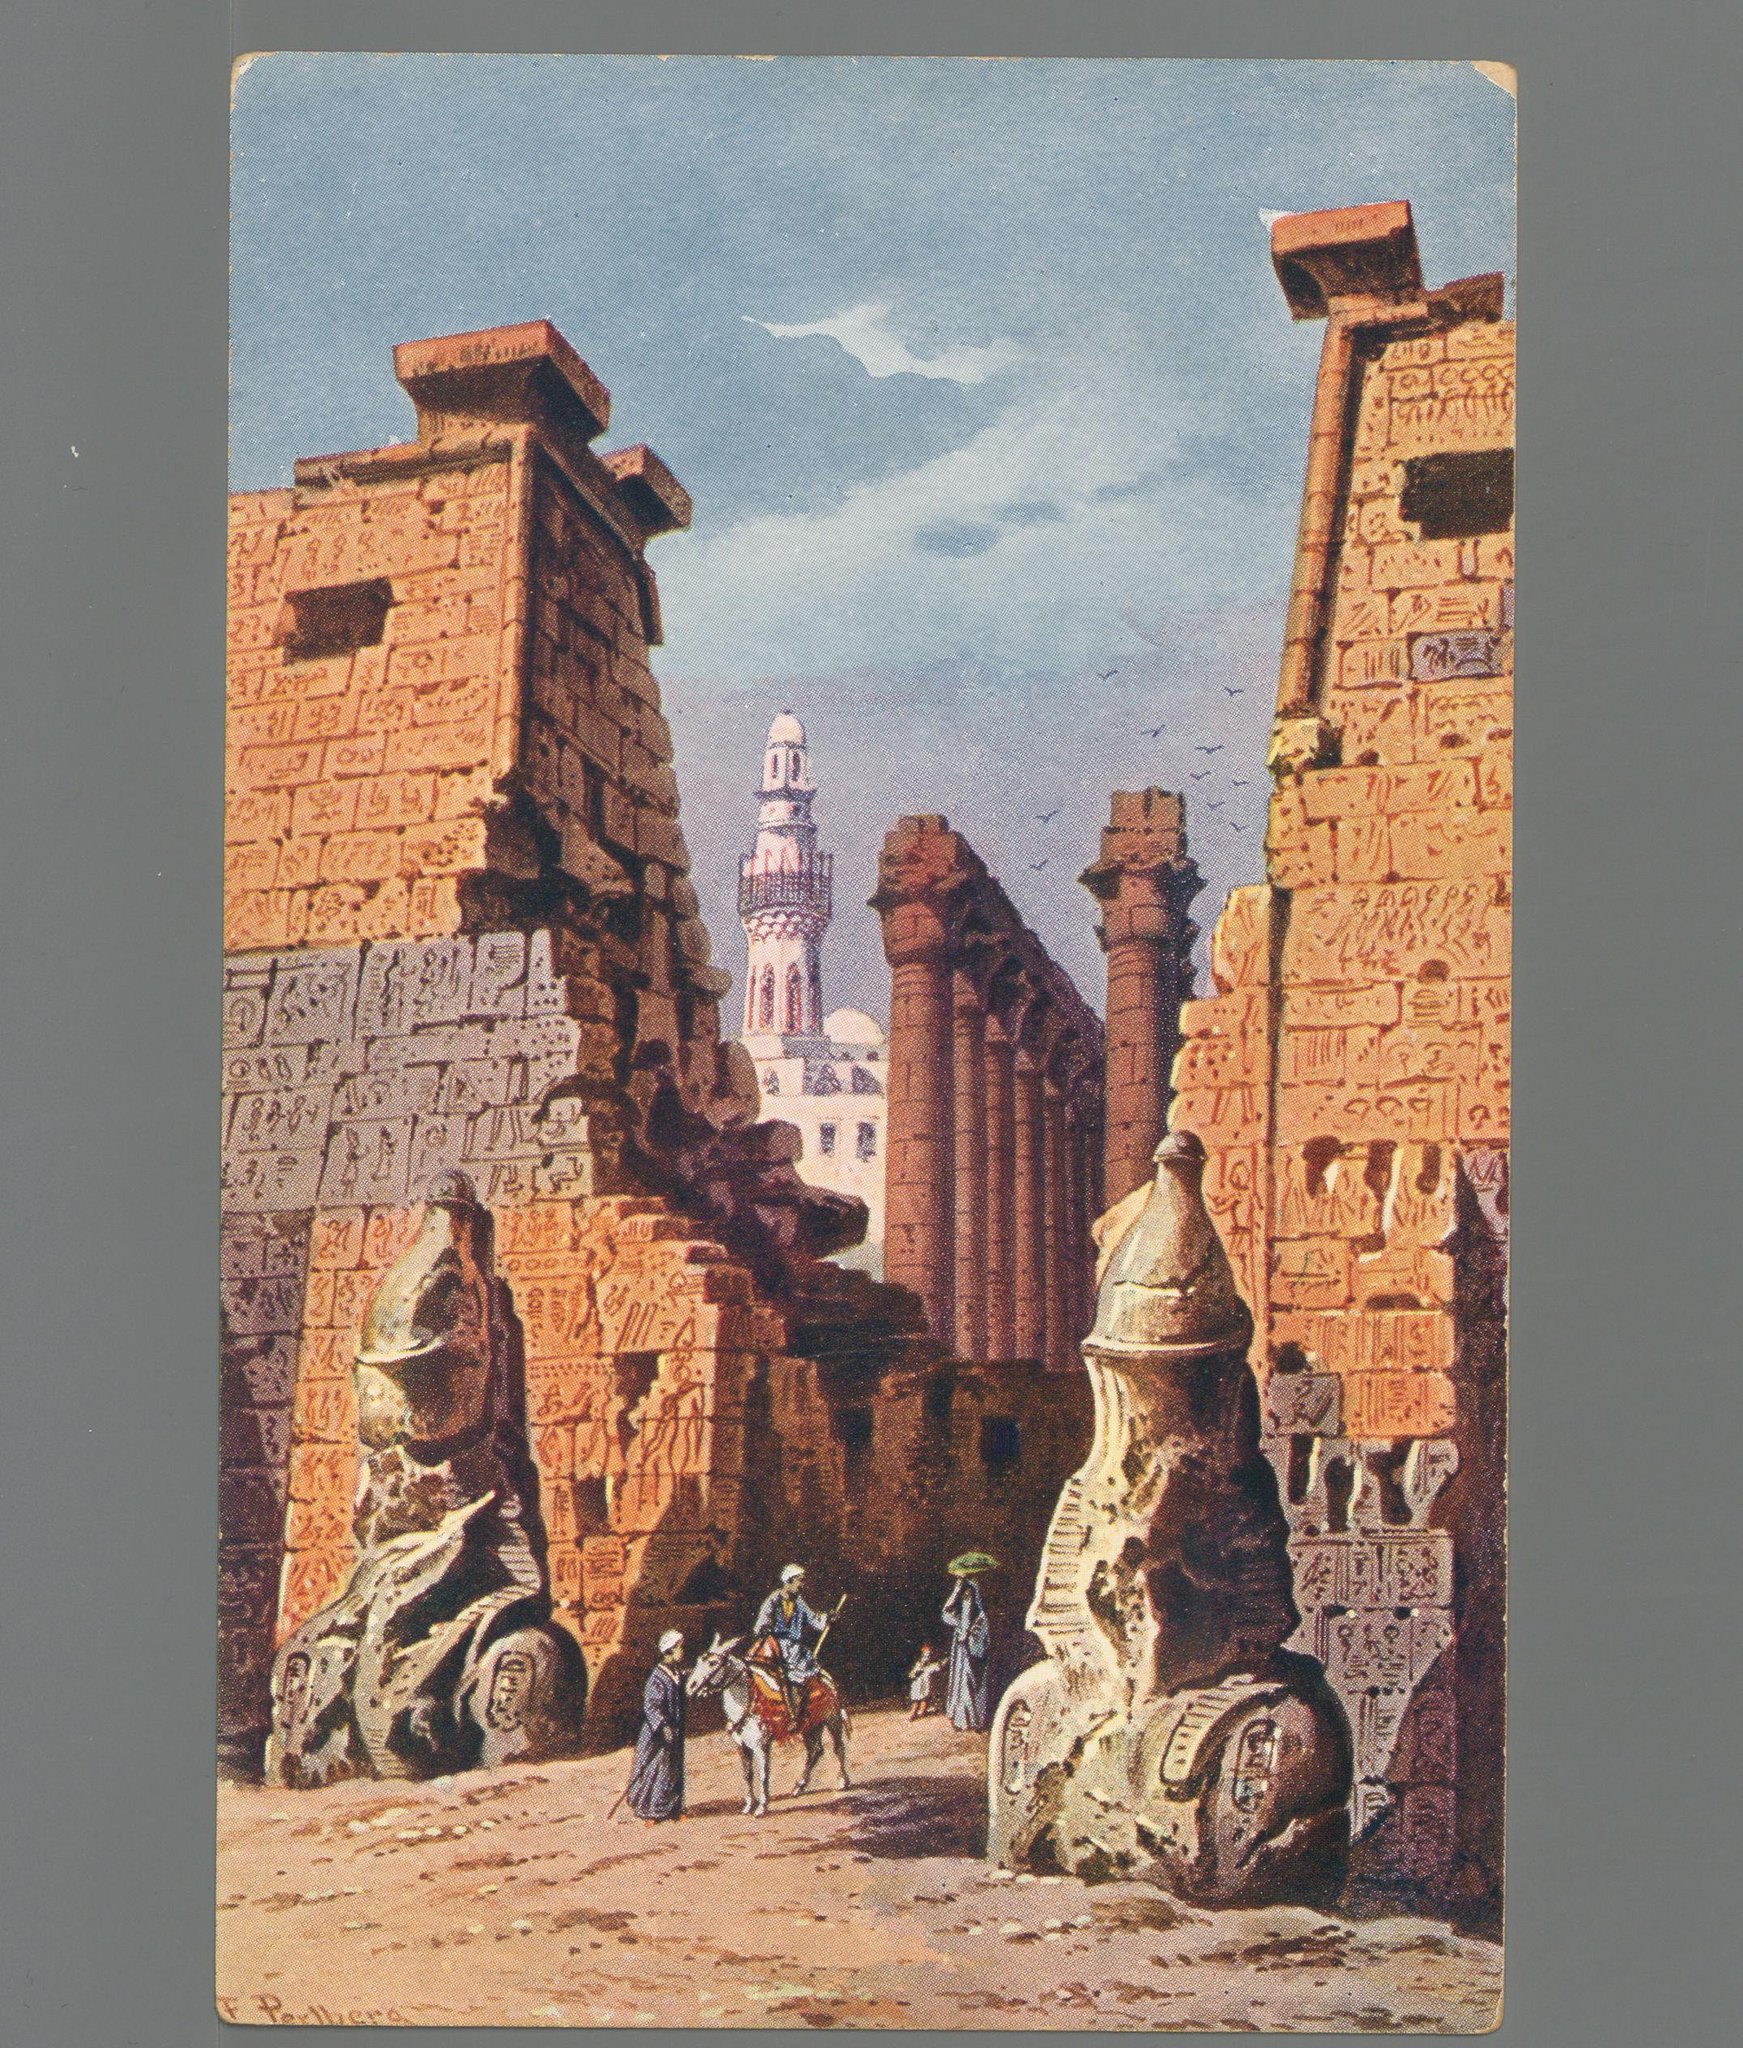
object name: photomechanical print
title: Temple à Luxor / Temple at Luxor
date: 1907-1930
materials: cardboard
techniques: color autotype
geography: dresden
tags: temple, shrine ~ egyptian religion, temple, shrine ~ islam, mohammedanism